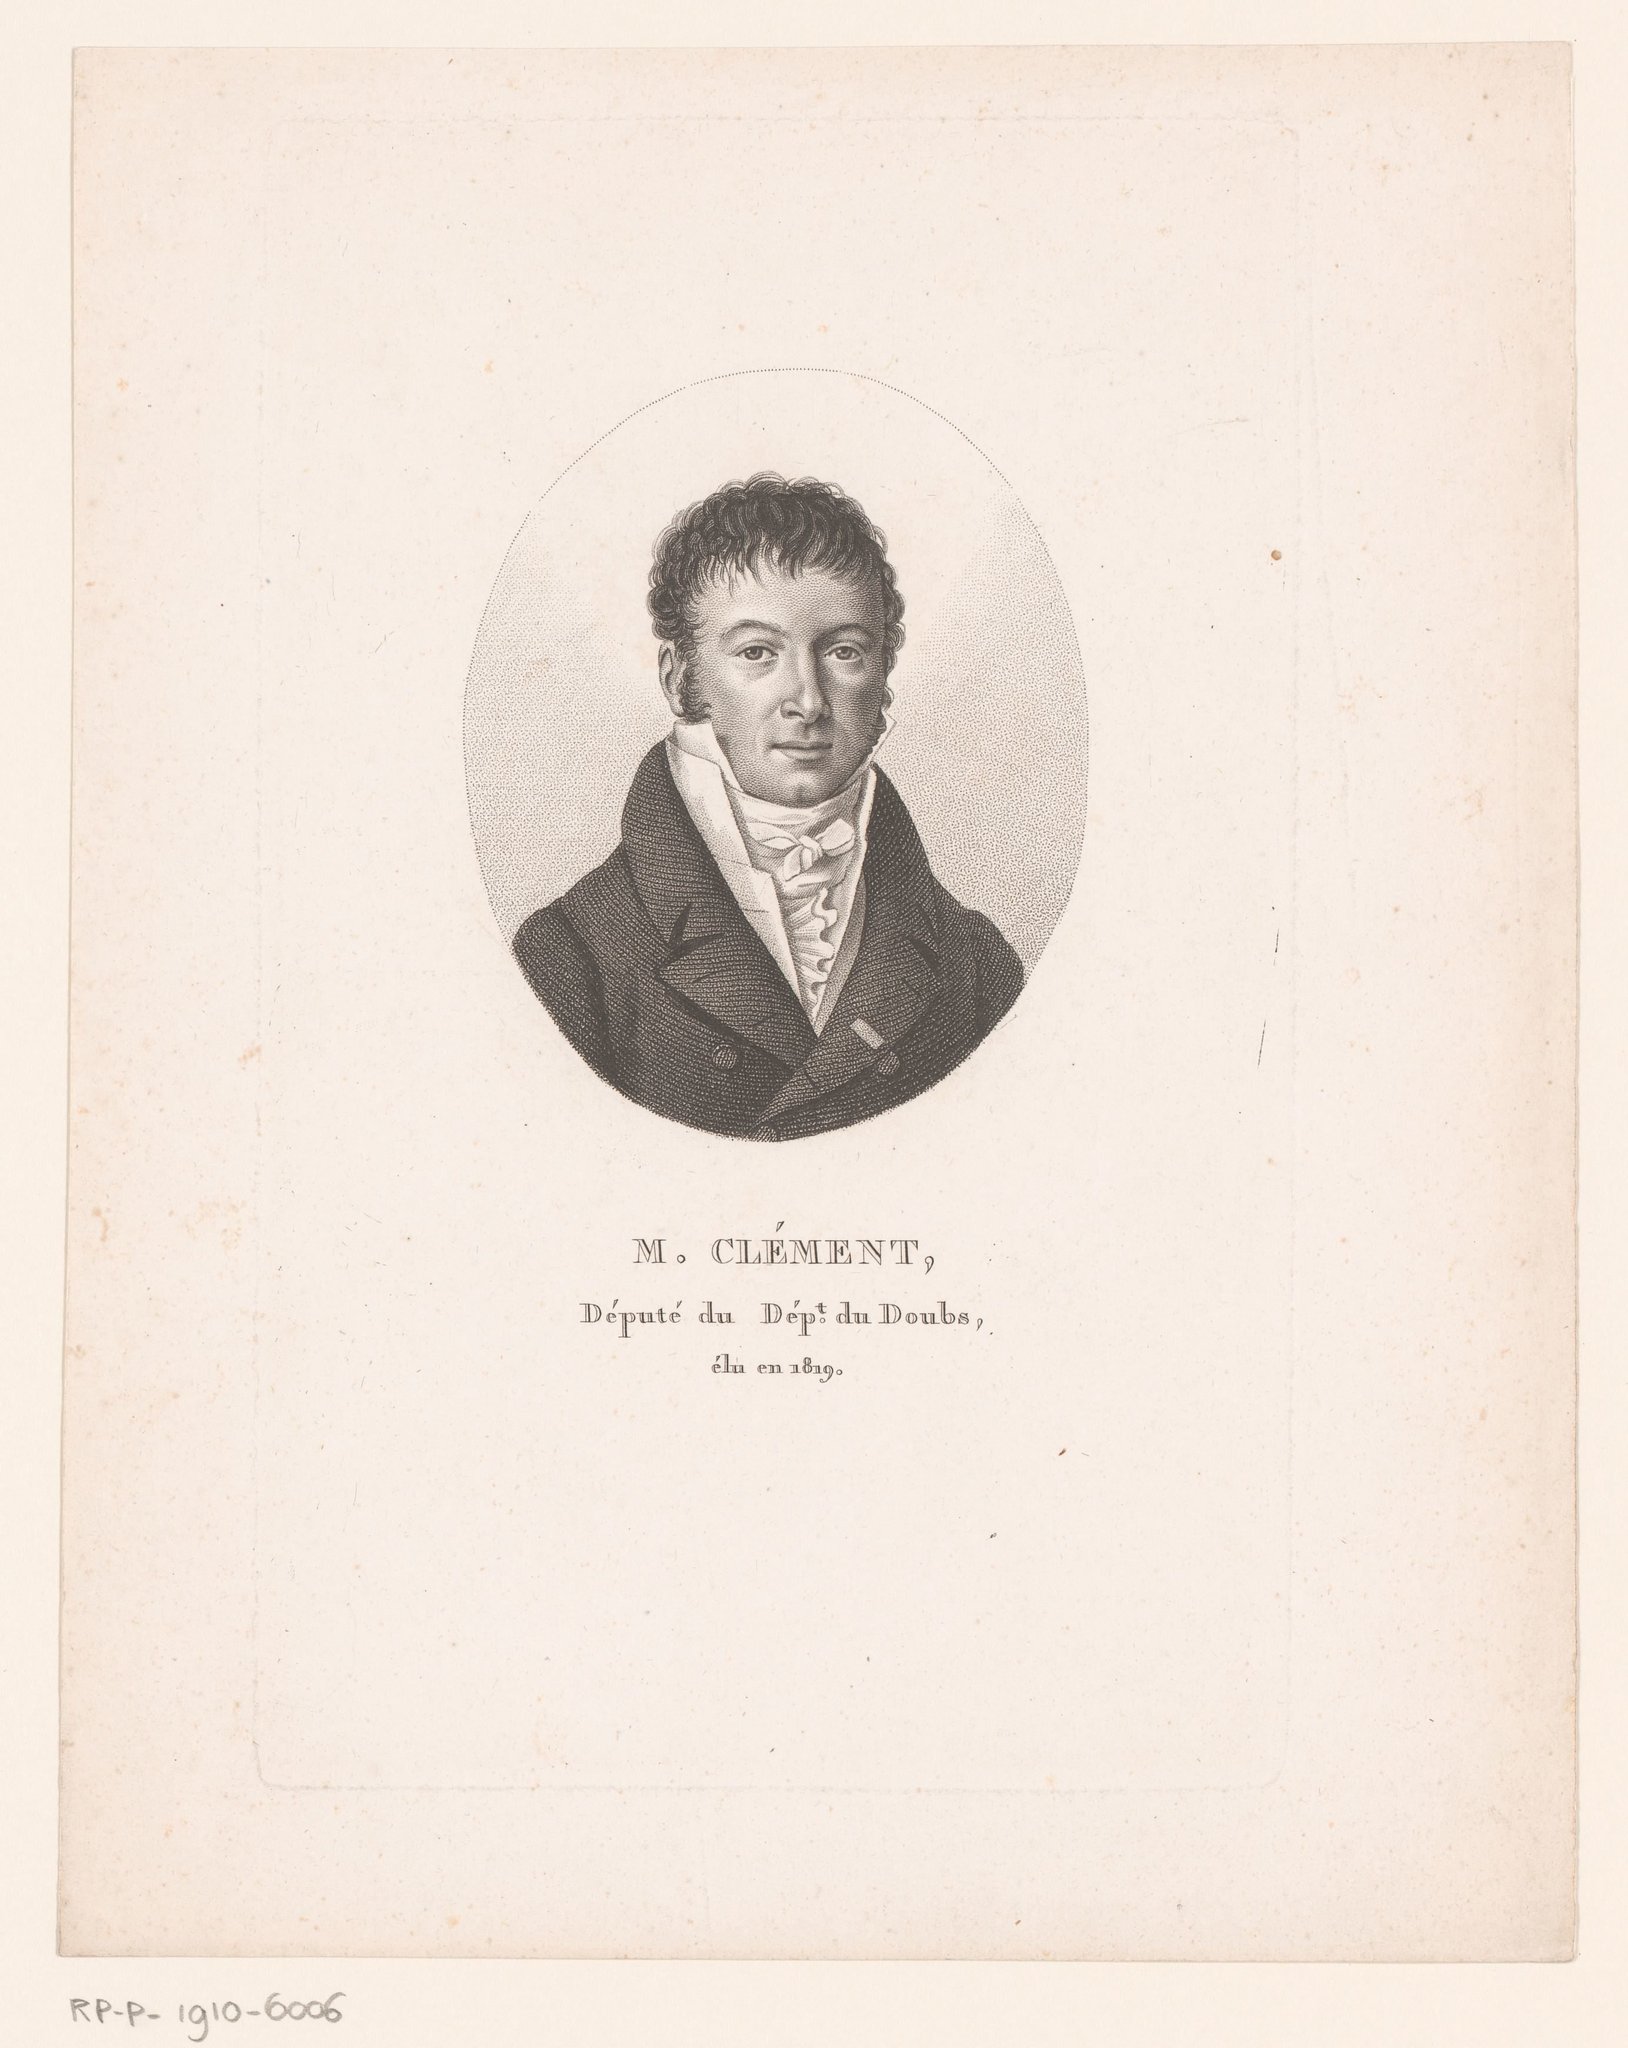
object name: book illustration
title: Portret van Charles-Louis Clément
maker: ambroise tardieu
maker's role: print maker, printer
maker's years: 1788-1841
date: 1820-1821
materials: paper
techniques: engraving, etching, roulette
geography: paris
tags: politician, historical persons, politician, e.g. party leader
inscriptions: collector's mark: Lugt 2228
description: Prent uit: Tardieu, Ambroise. Portraits des députés, écrivains et pairs constitutionnels, défenseurs invariables de la charte et de la loi des élections du 5 février 1817. Parijs: Tardieu, Ambroise, 1820-1821.